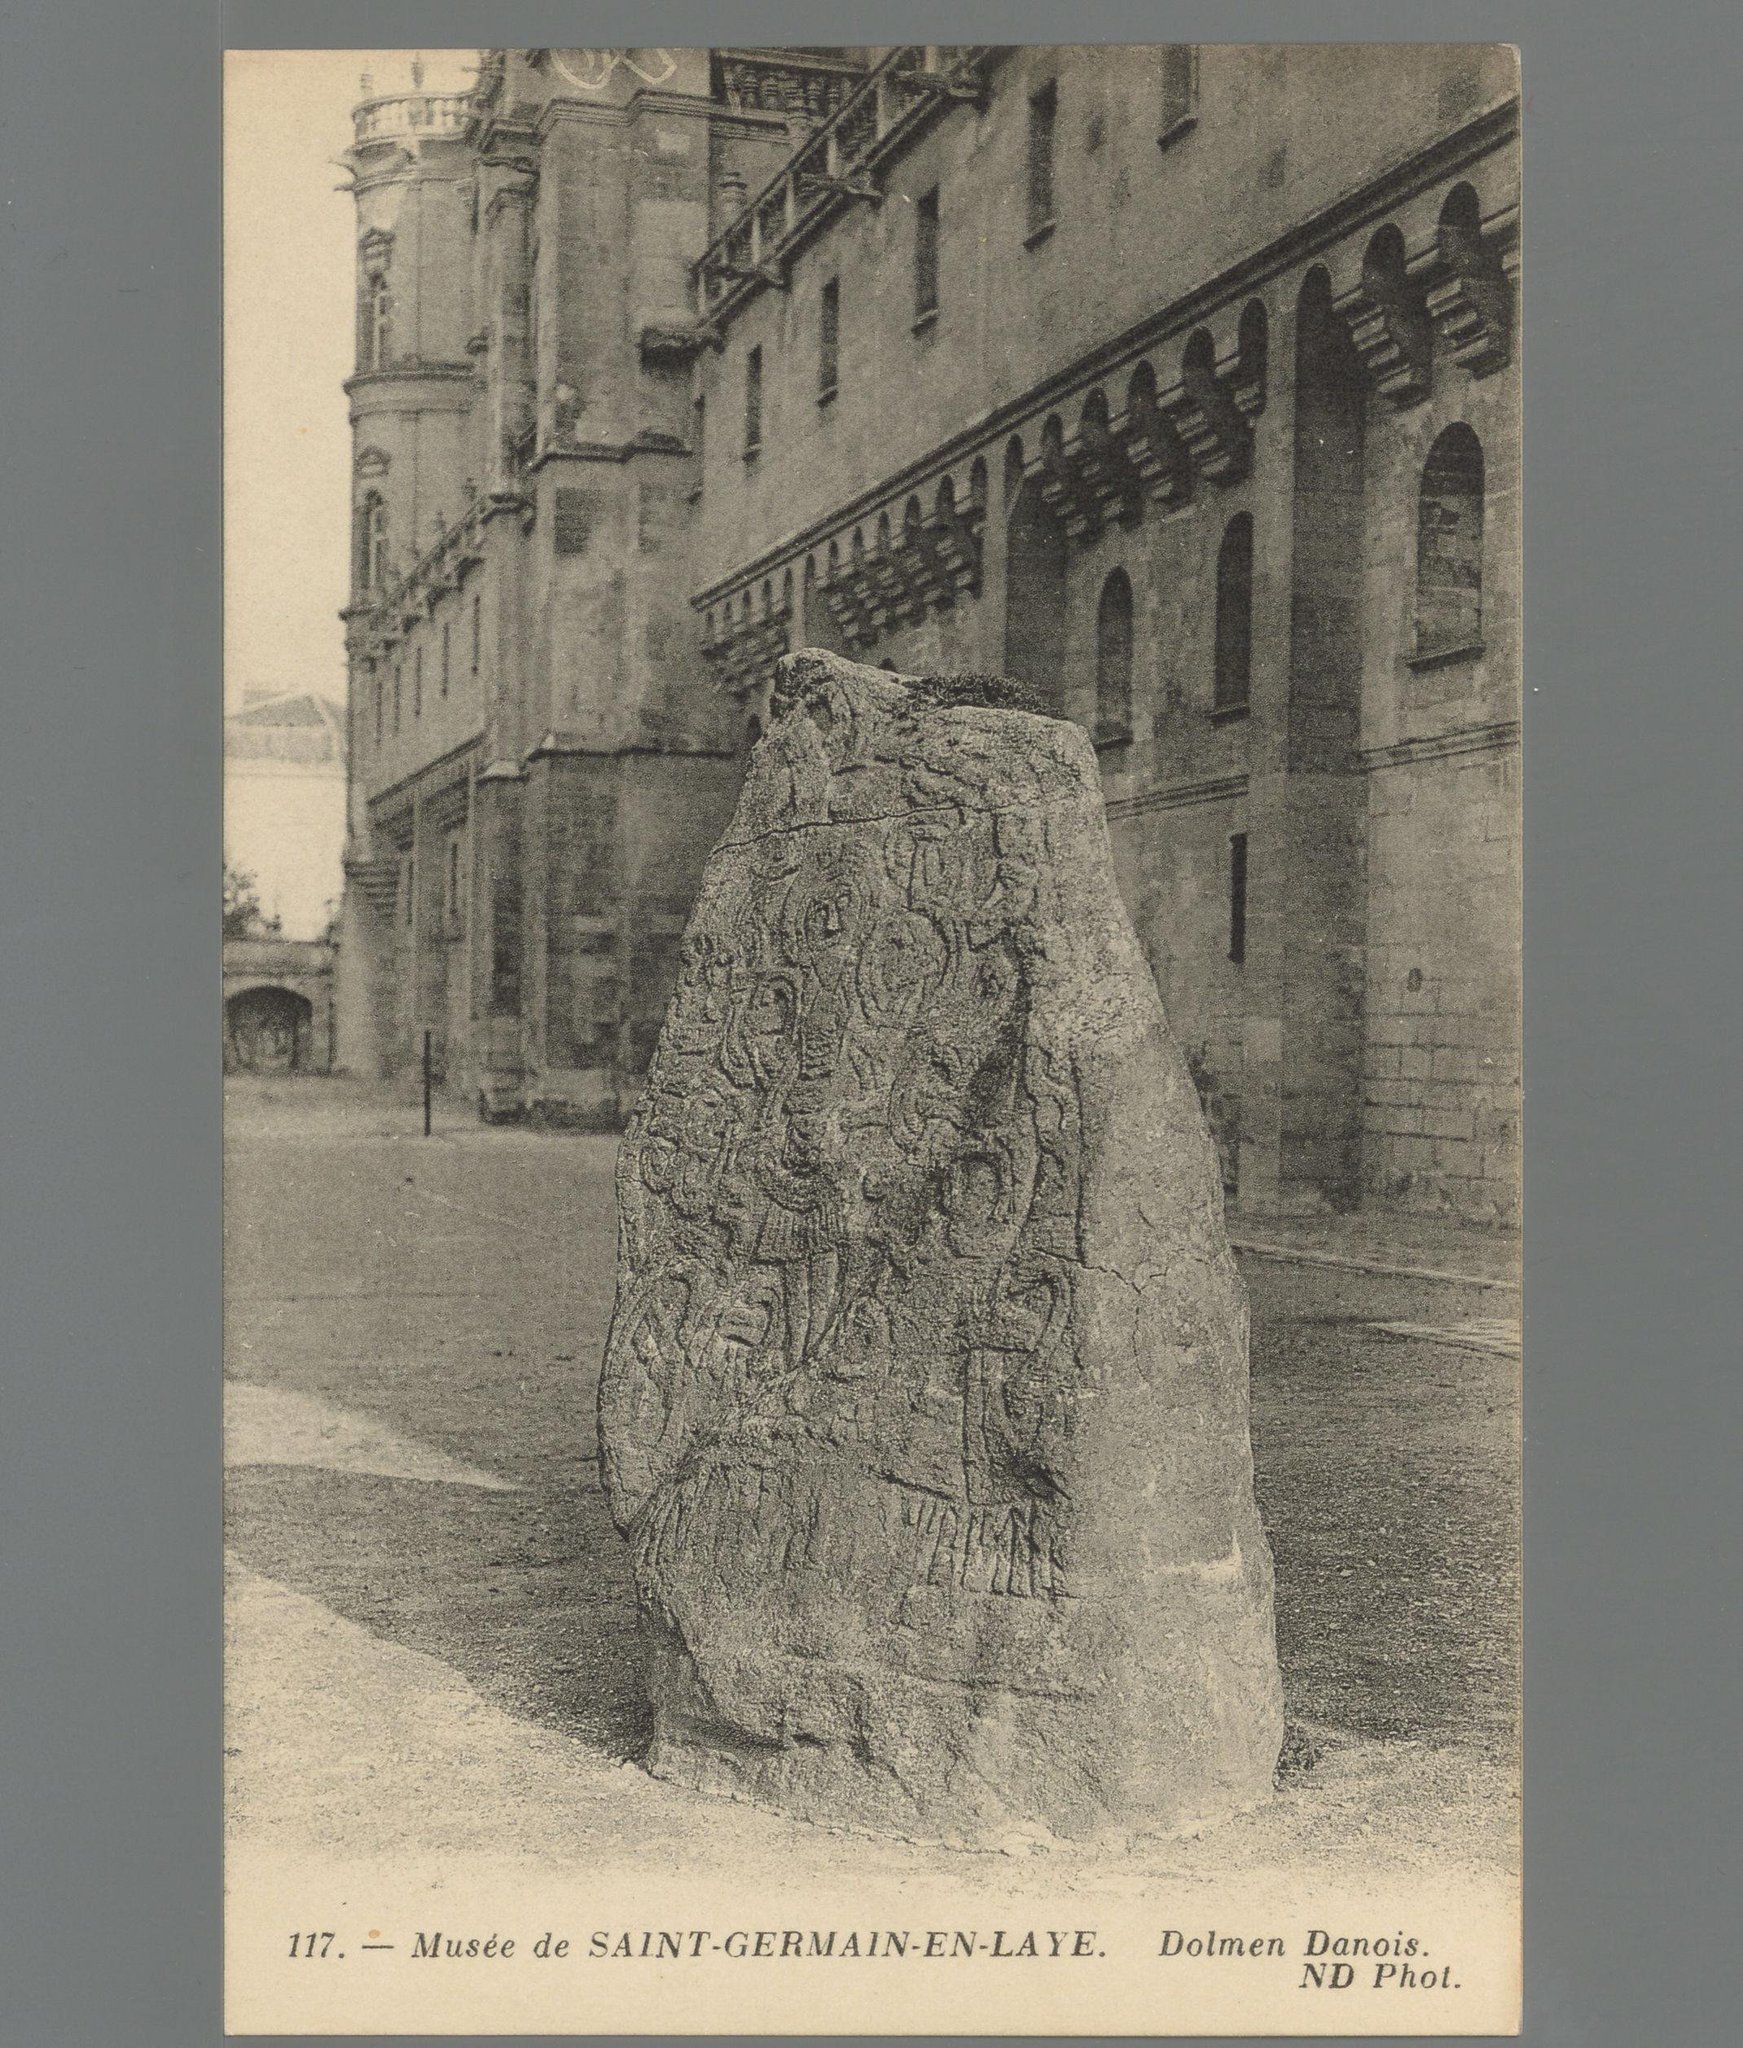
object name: photomechanical print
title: Dolmen Danois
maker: Anonymous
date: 1903-1918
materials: cardboard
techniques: photograph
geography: paris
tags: permanent exhibition, museum, megalithic chambered tomb, dolmen